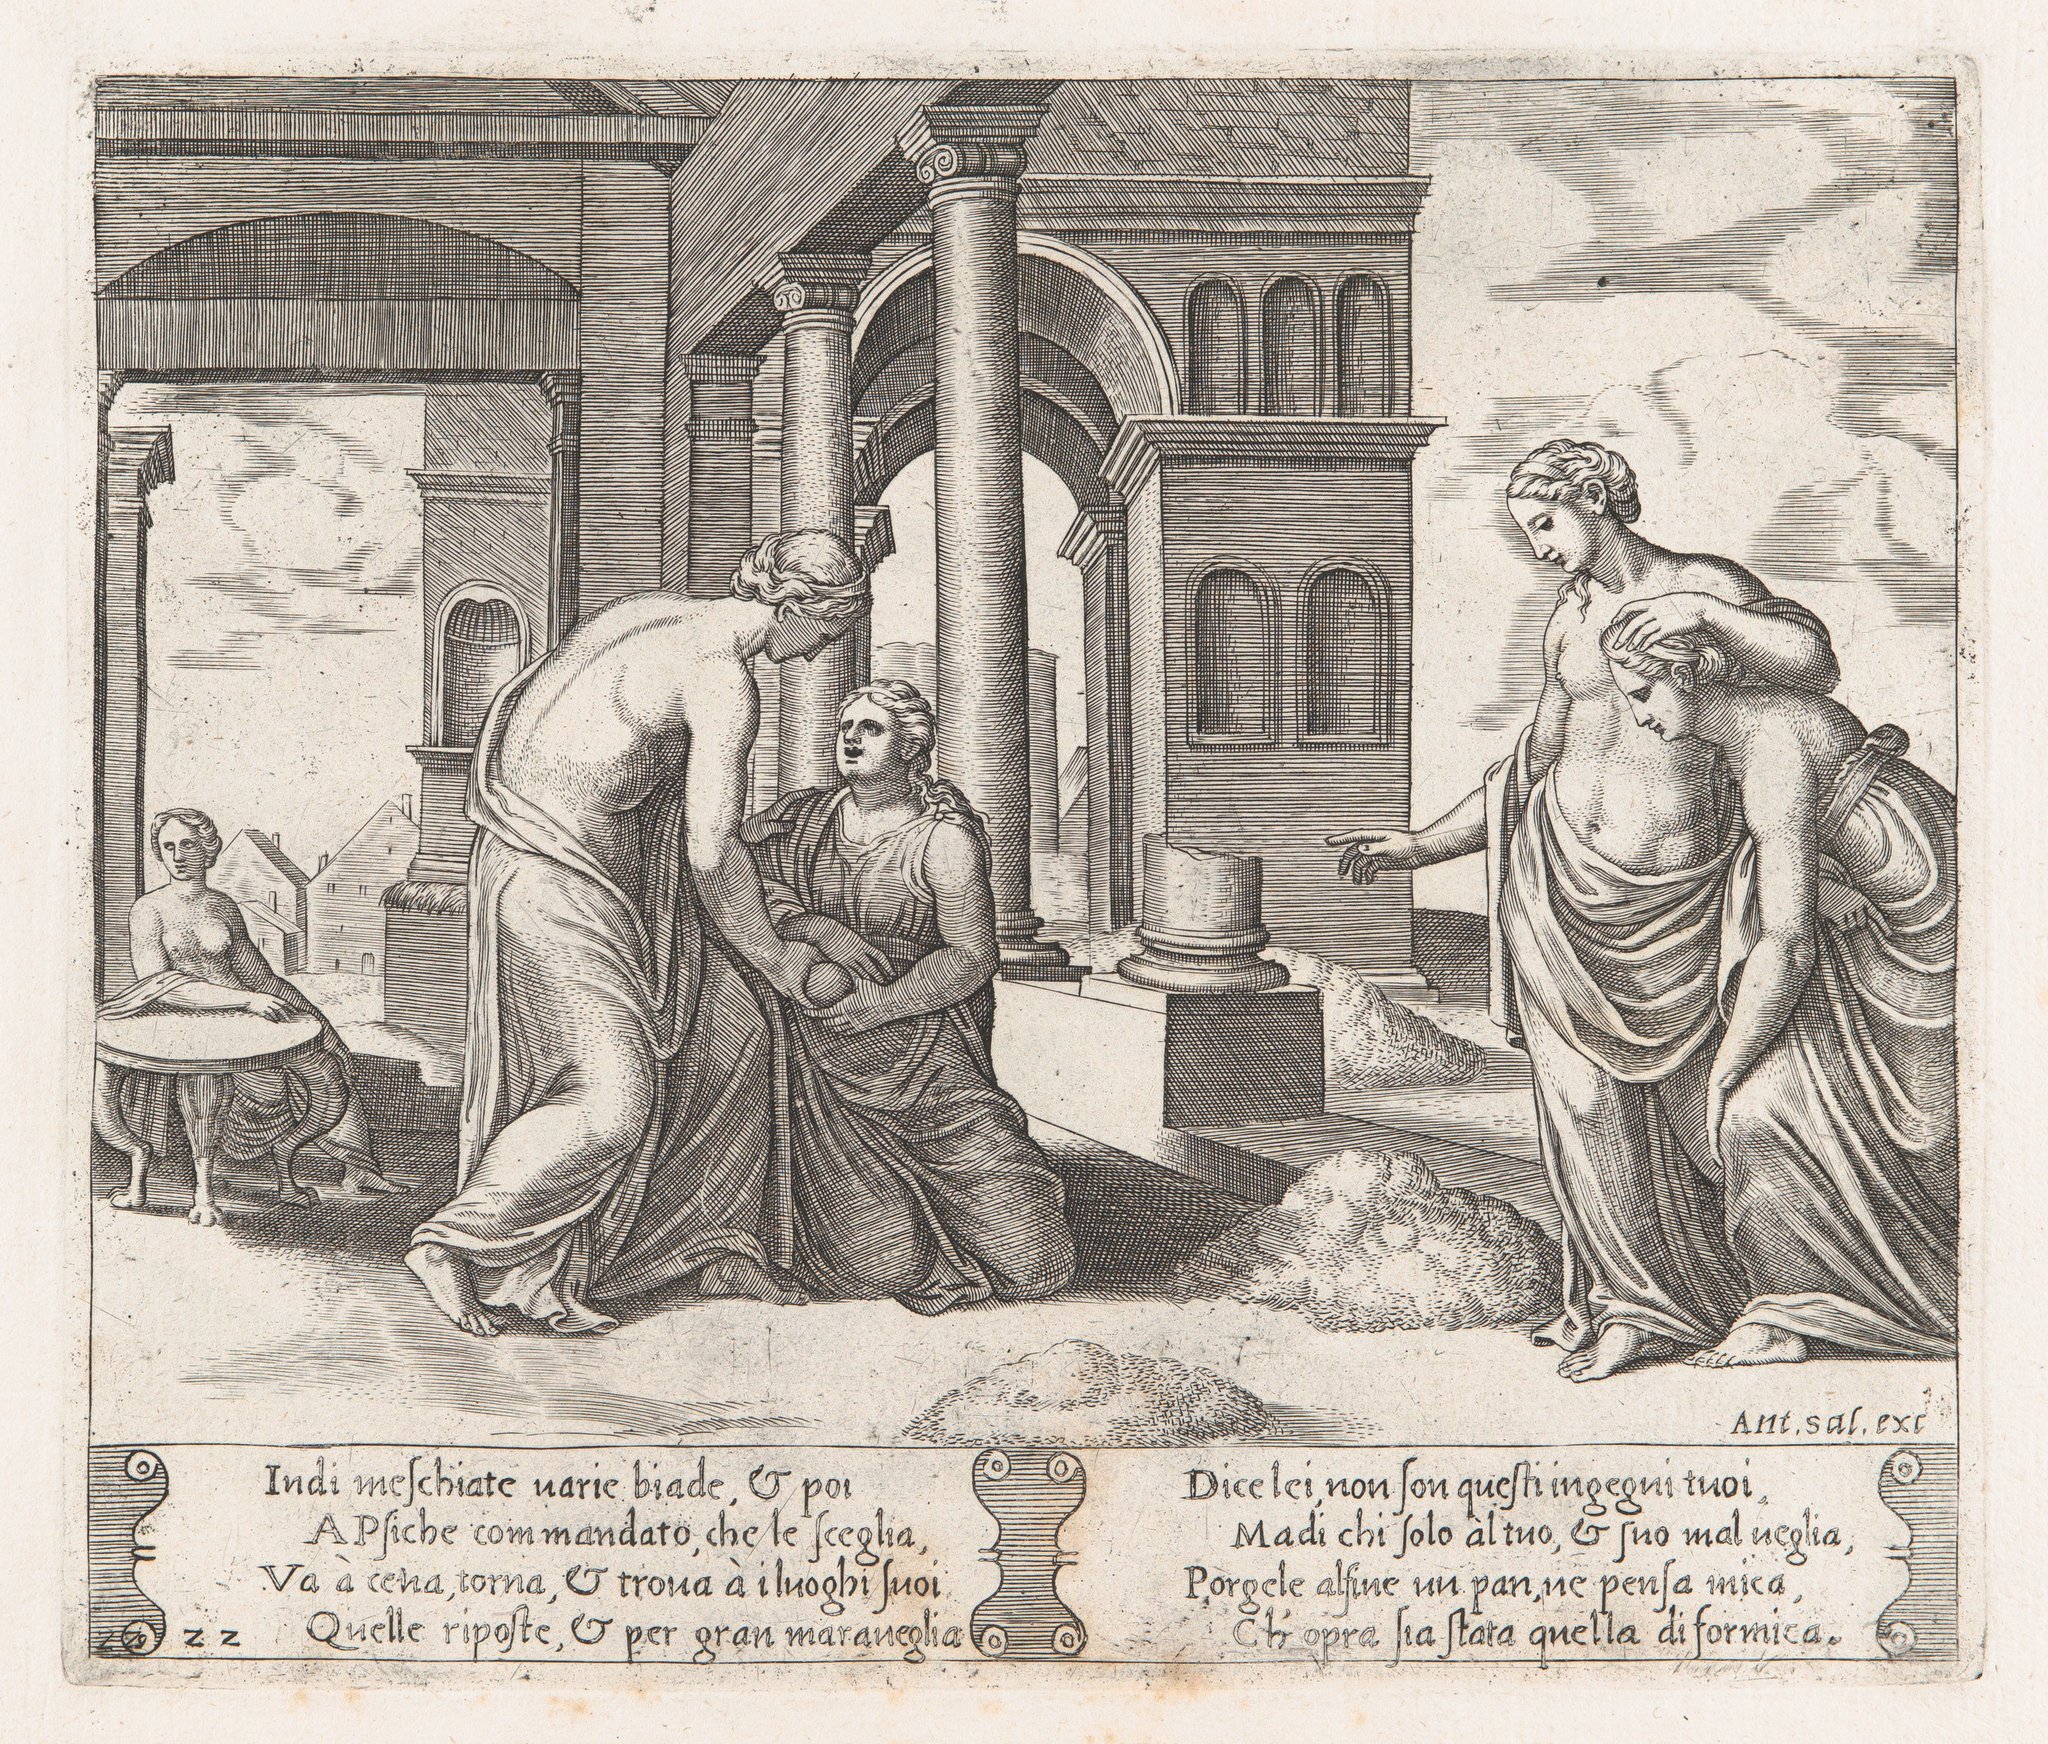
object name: print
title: Plate 22: Venus standing at right ordering Psyche to sort a pile of grain, at left the same pair hold a loaf of bread, from "The Story of Cupid and Psyche as told by Apuleius"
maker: master of the die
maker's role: artist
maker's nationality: italian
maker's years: 1525-1560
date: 1530-1560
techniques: engraving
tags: buildings,cupid,psyche,venus